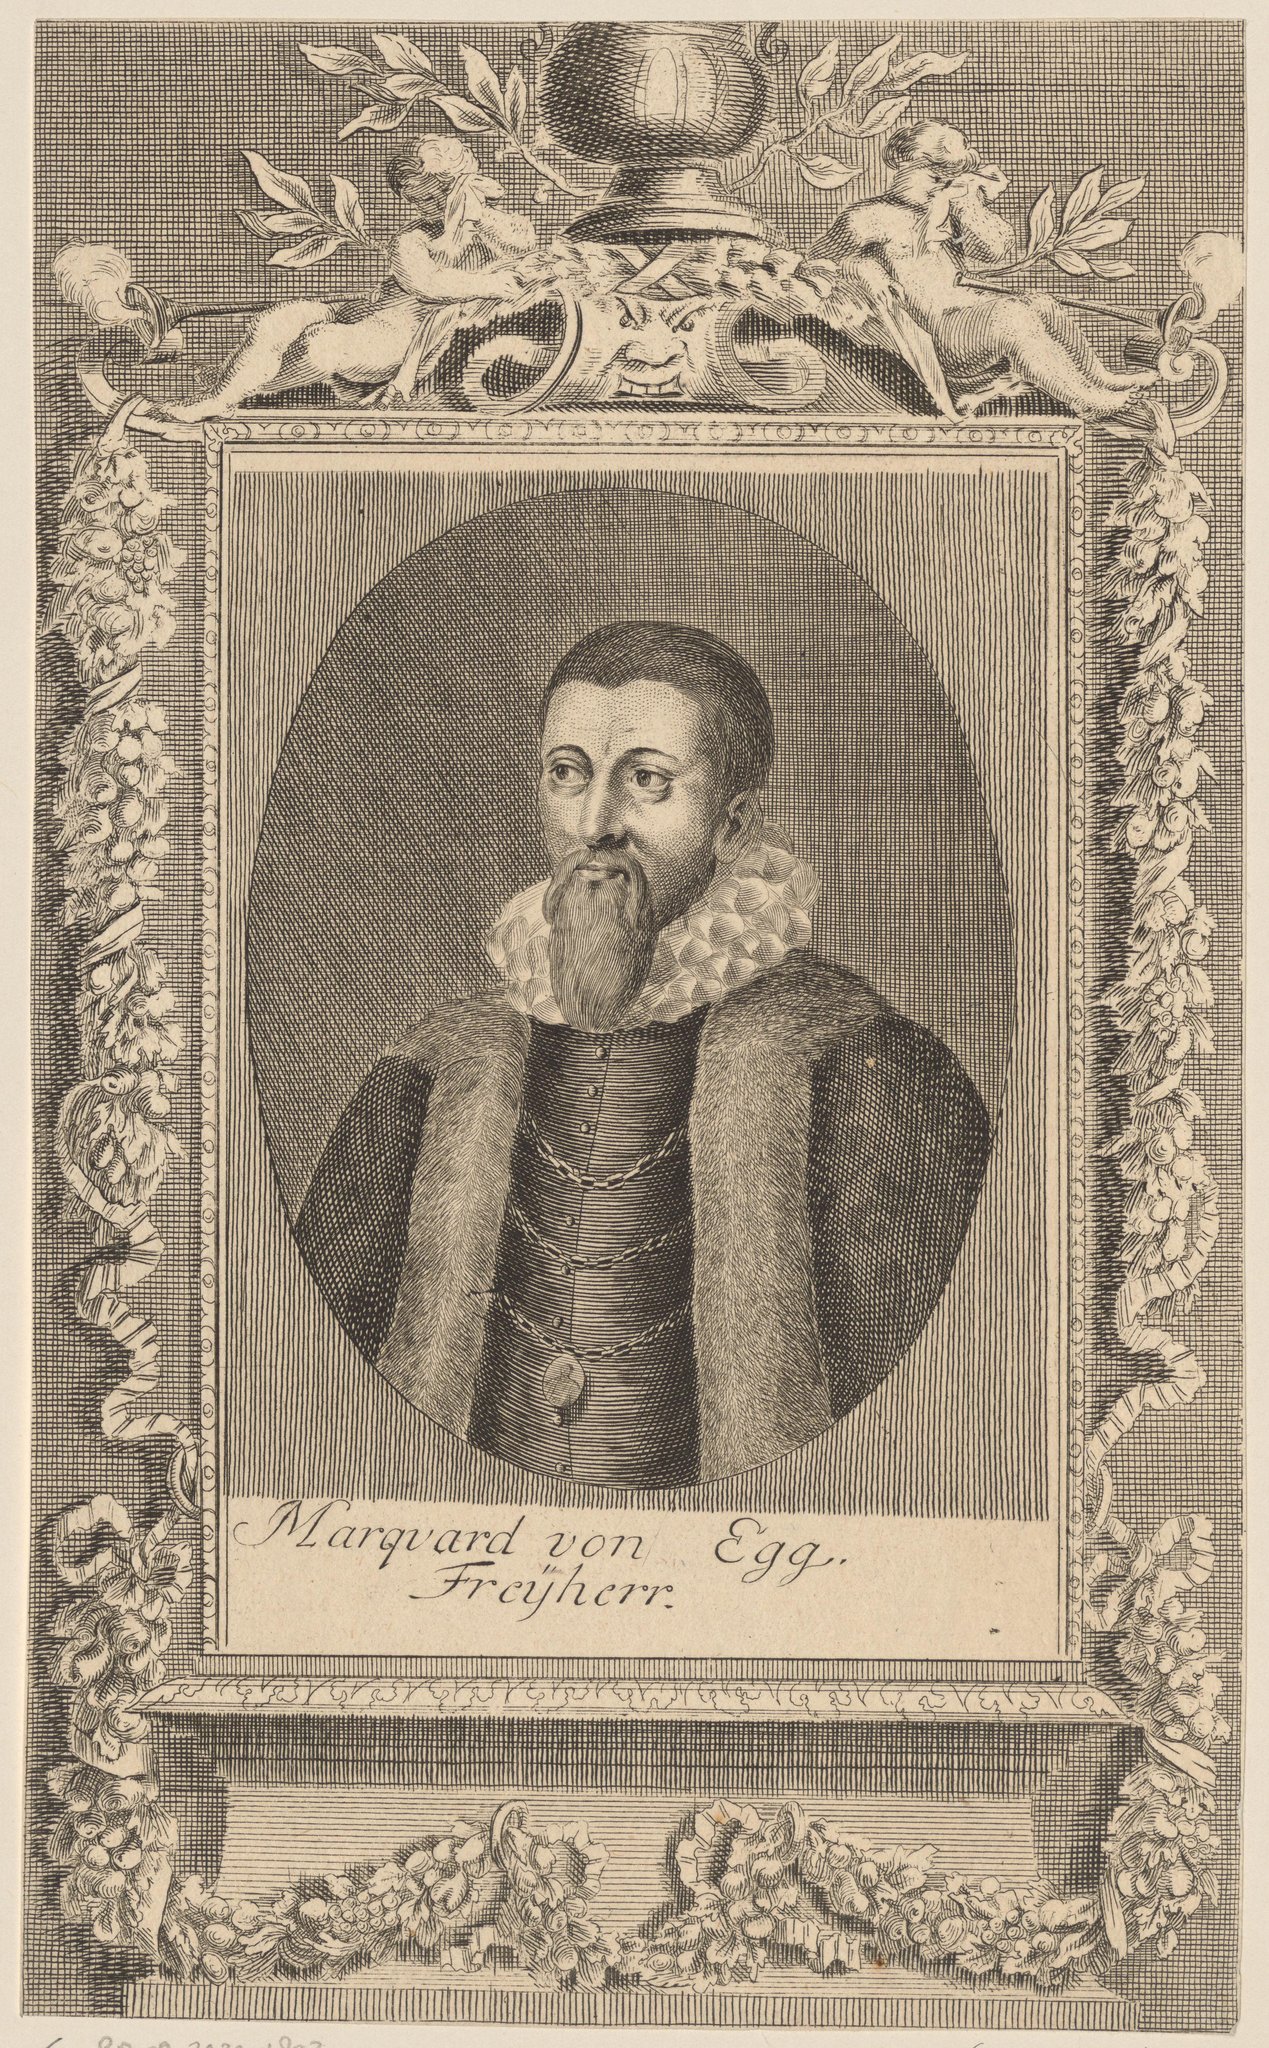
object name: print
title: Portret van Marquard von Egg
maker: Anonymous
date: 1722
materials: paper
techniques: engraving, etching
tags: historical persons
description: Prent in latere staat gebruikt in: Khevenhüller, Franz Christoph von. Annales Ferdinandei: So von Kaysers Ferdinand deß Andern Geburth (...). Leipzig: Moritz Georg Weidmann, 1722, dl. 2.